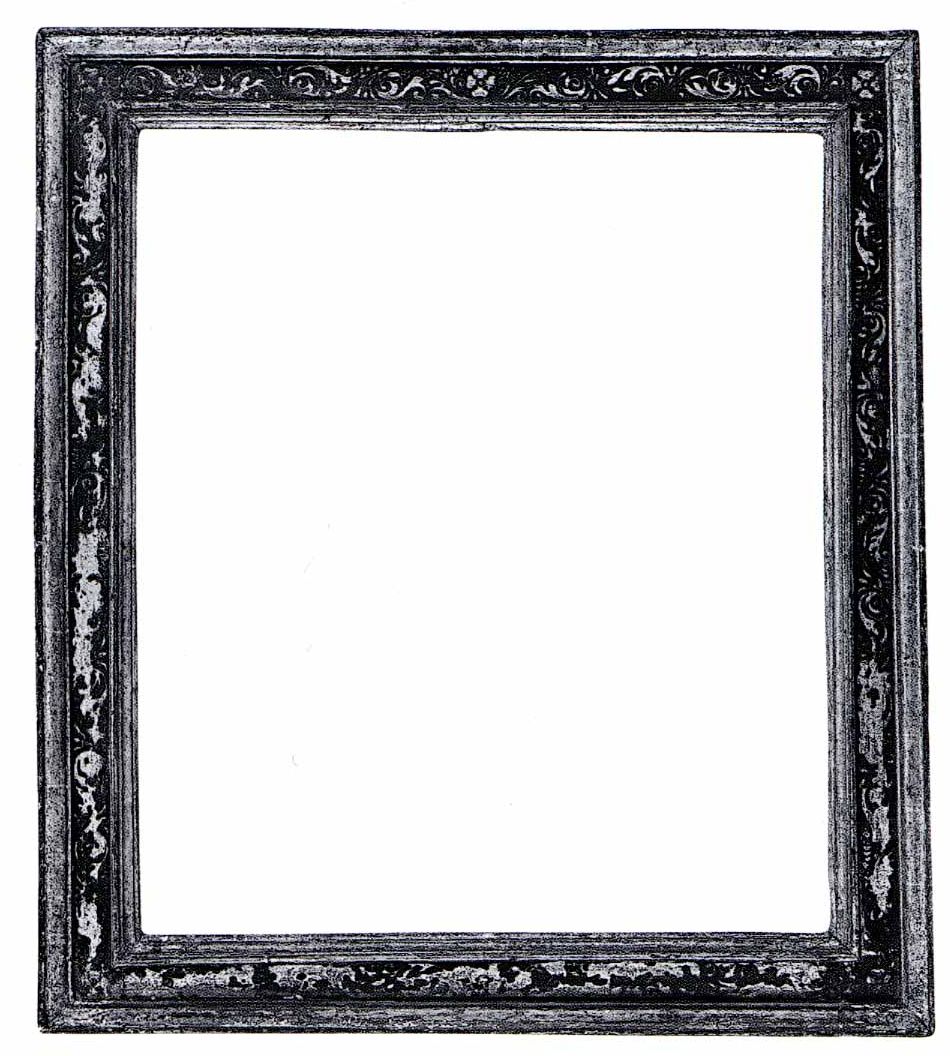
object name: frame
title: Cassetta frame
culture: venetian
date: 1500-1510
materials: canvas, gilt, wood